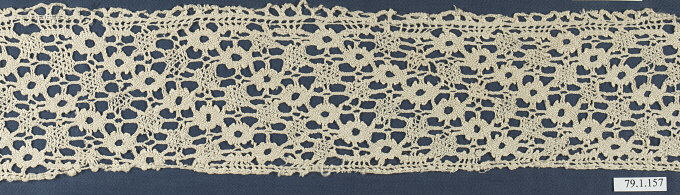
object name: strip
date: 1600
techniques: lace